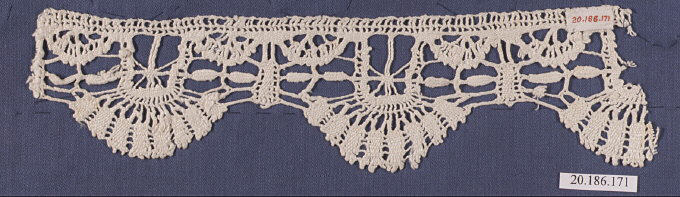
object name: edging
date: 1601-1700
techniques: lace